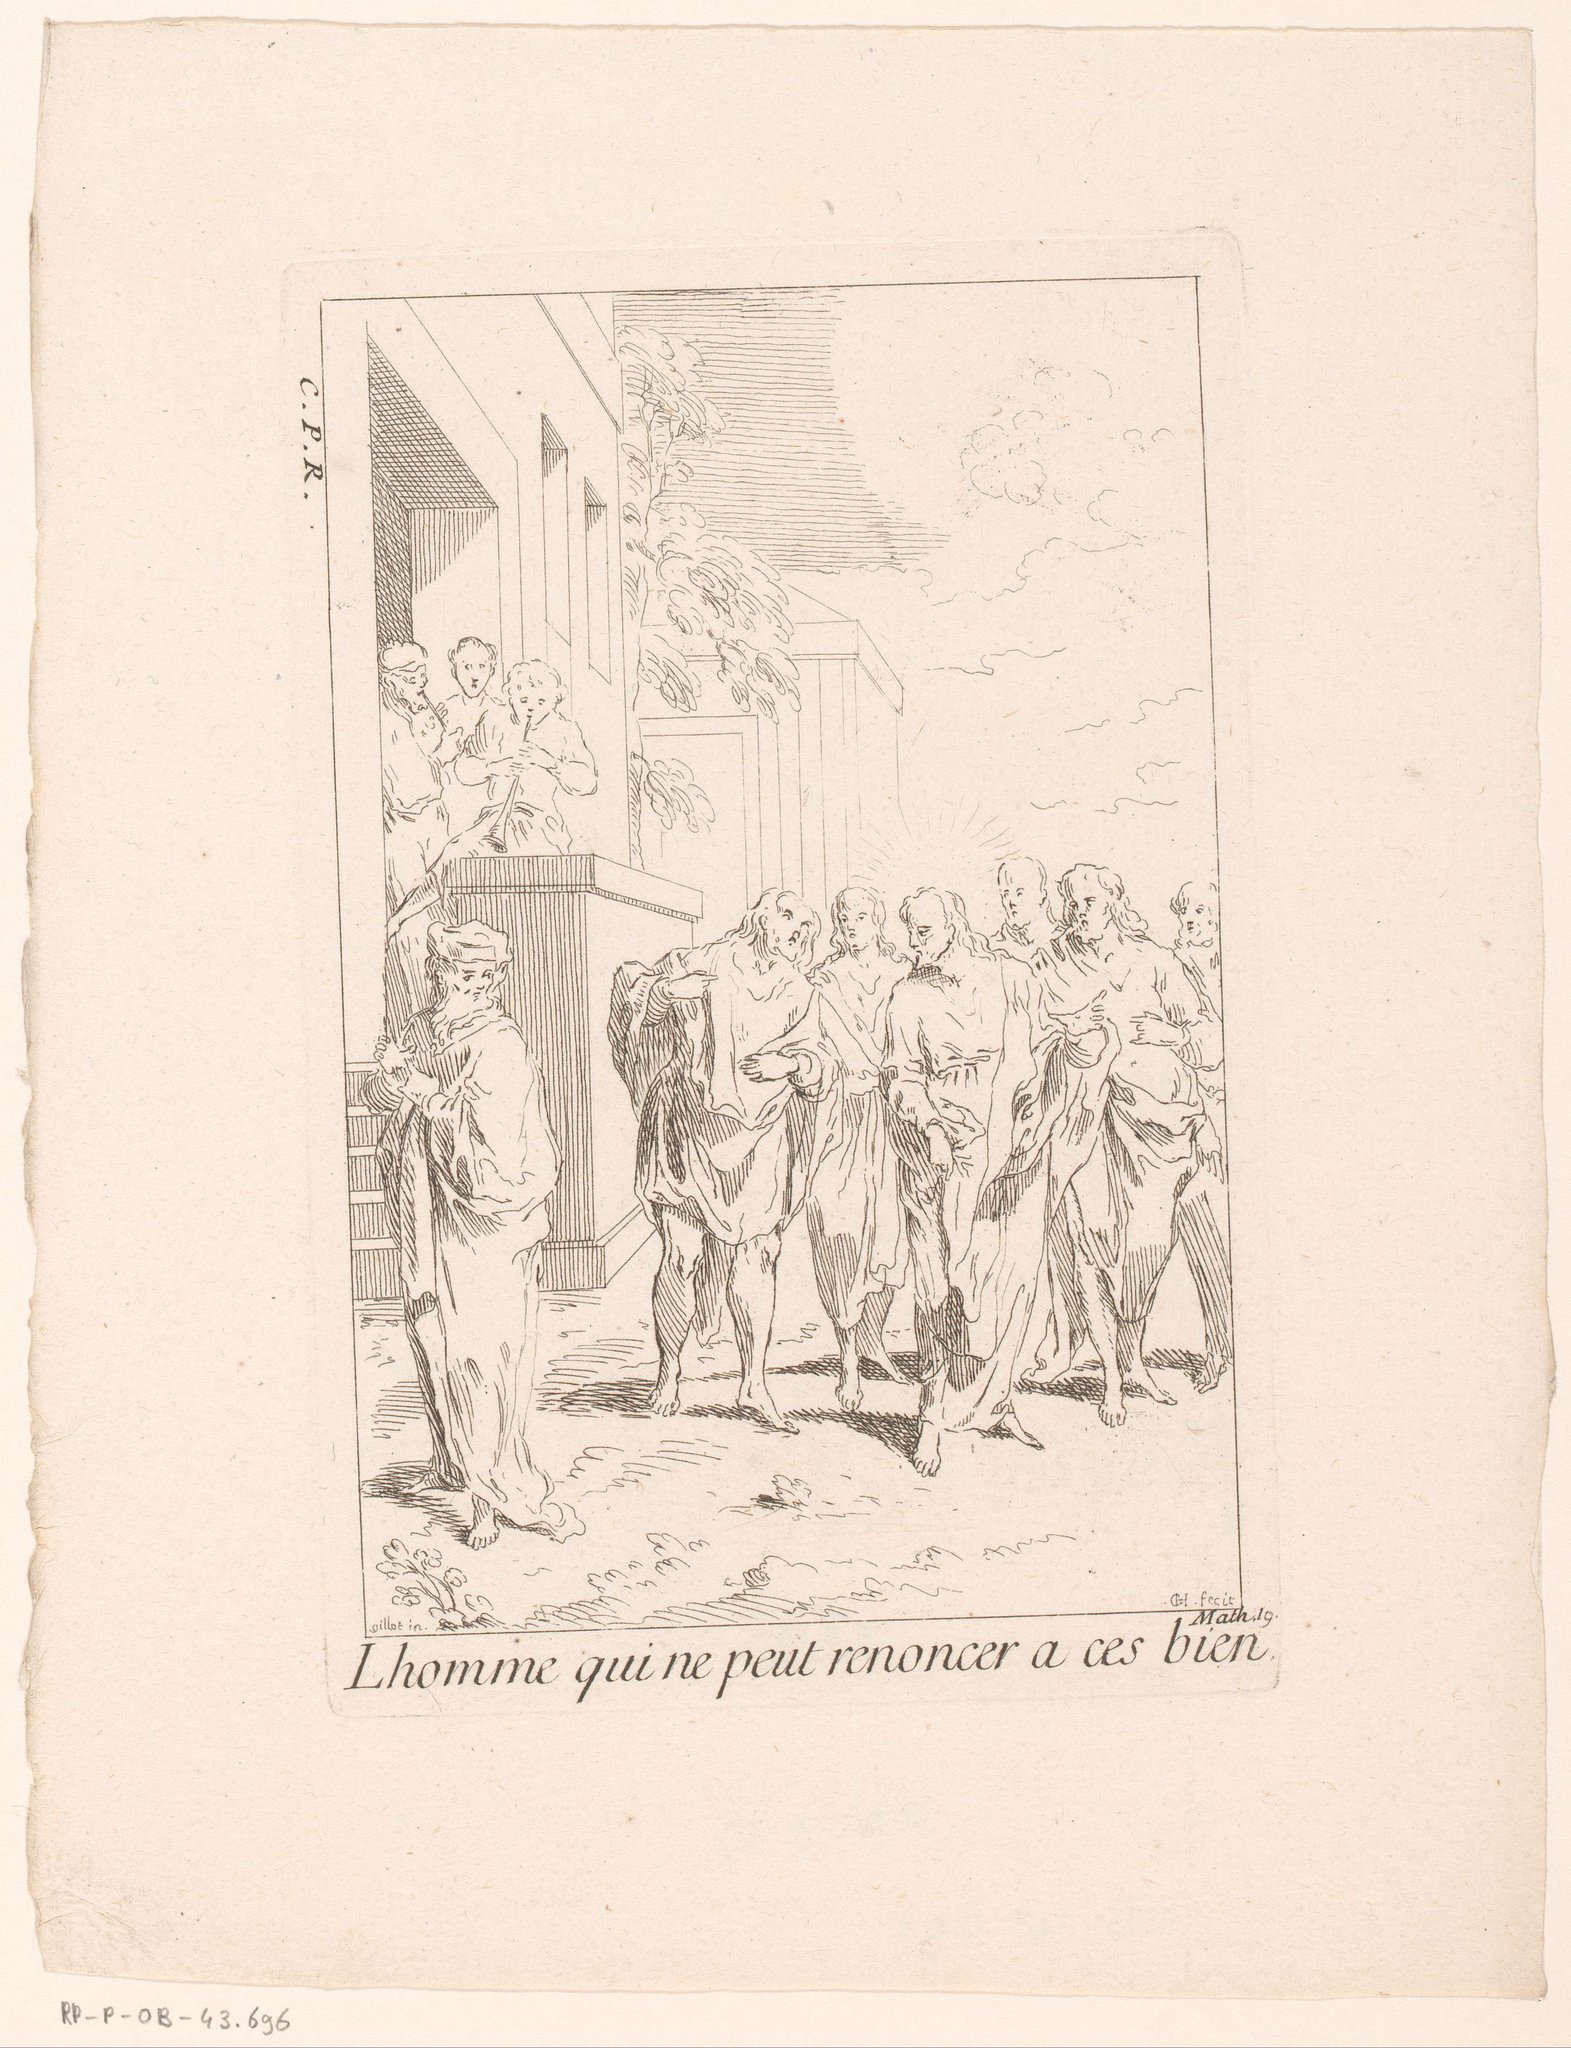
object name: print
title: Leven en passie van Christus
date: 1705-1732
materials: paper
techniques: etching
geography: paris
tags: christ urges a rich young man (a certain ruler), who is kneeling before him, to seek perfection (matthew 19:16-22; mark 10:17-22; luke 18:18-23)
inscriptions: collector's mark: Lugt 2228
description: Maakt deel uit van een serie met zestig prenten met als thema het leven van Christus.